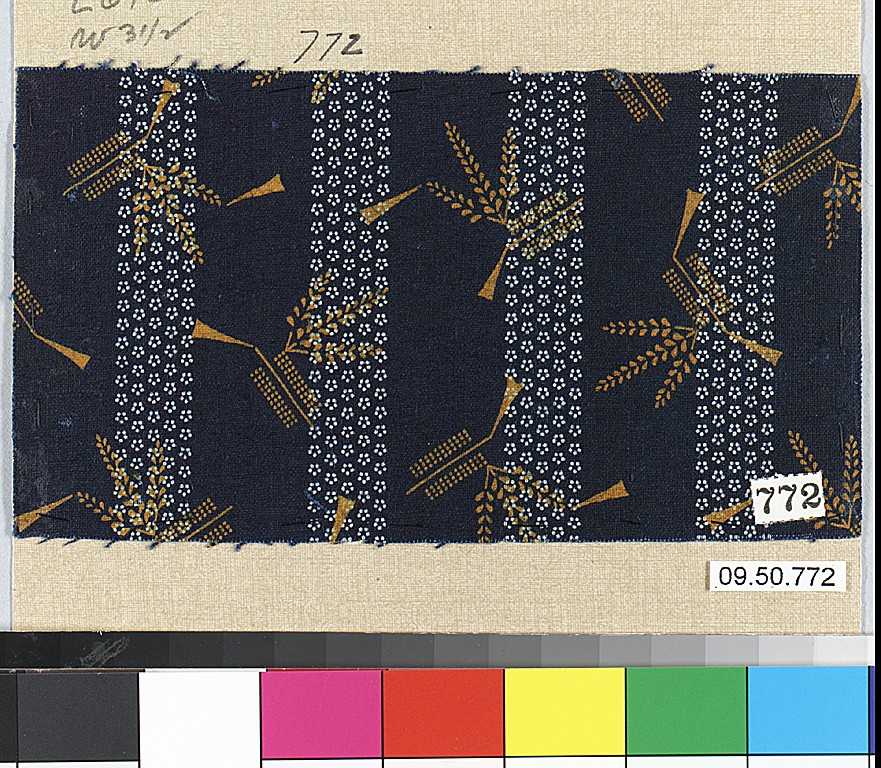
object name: piece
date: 1801-1900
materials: cotton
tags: flowers,leaves